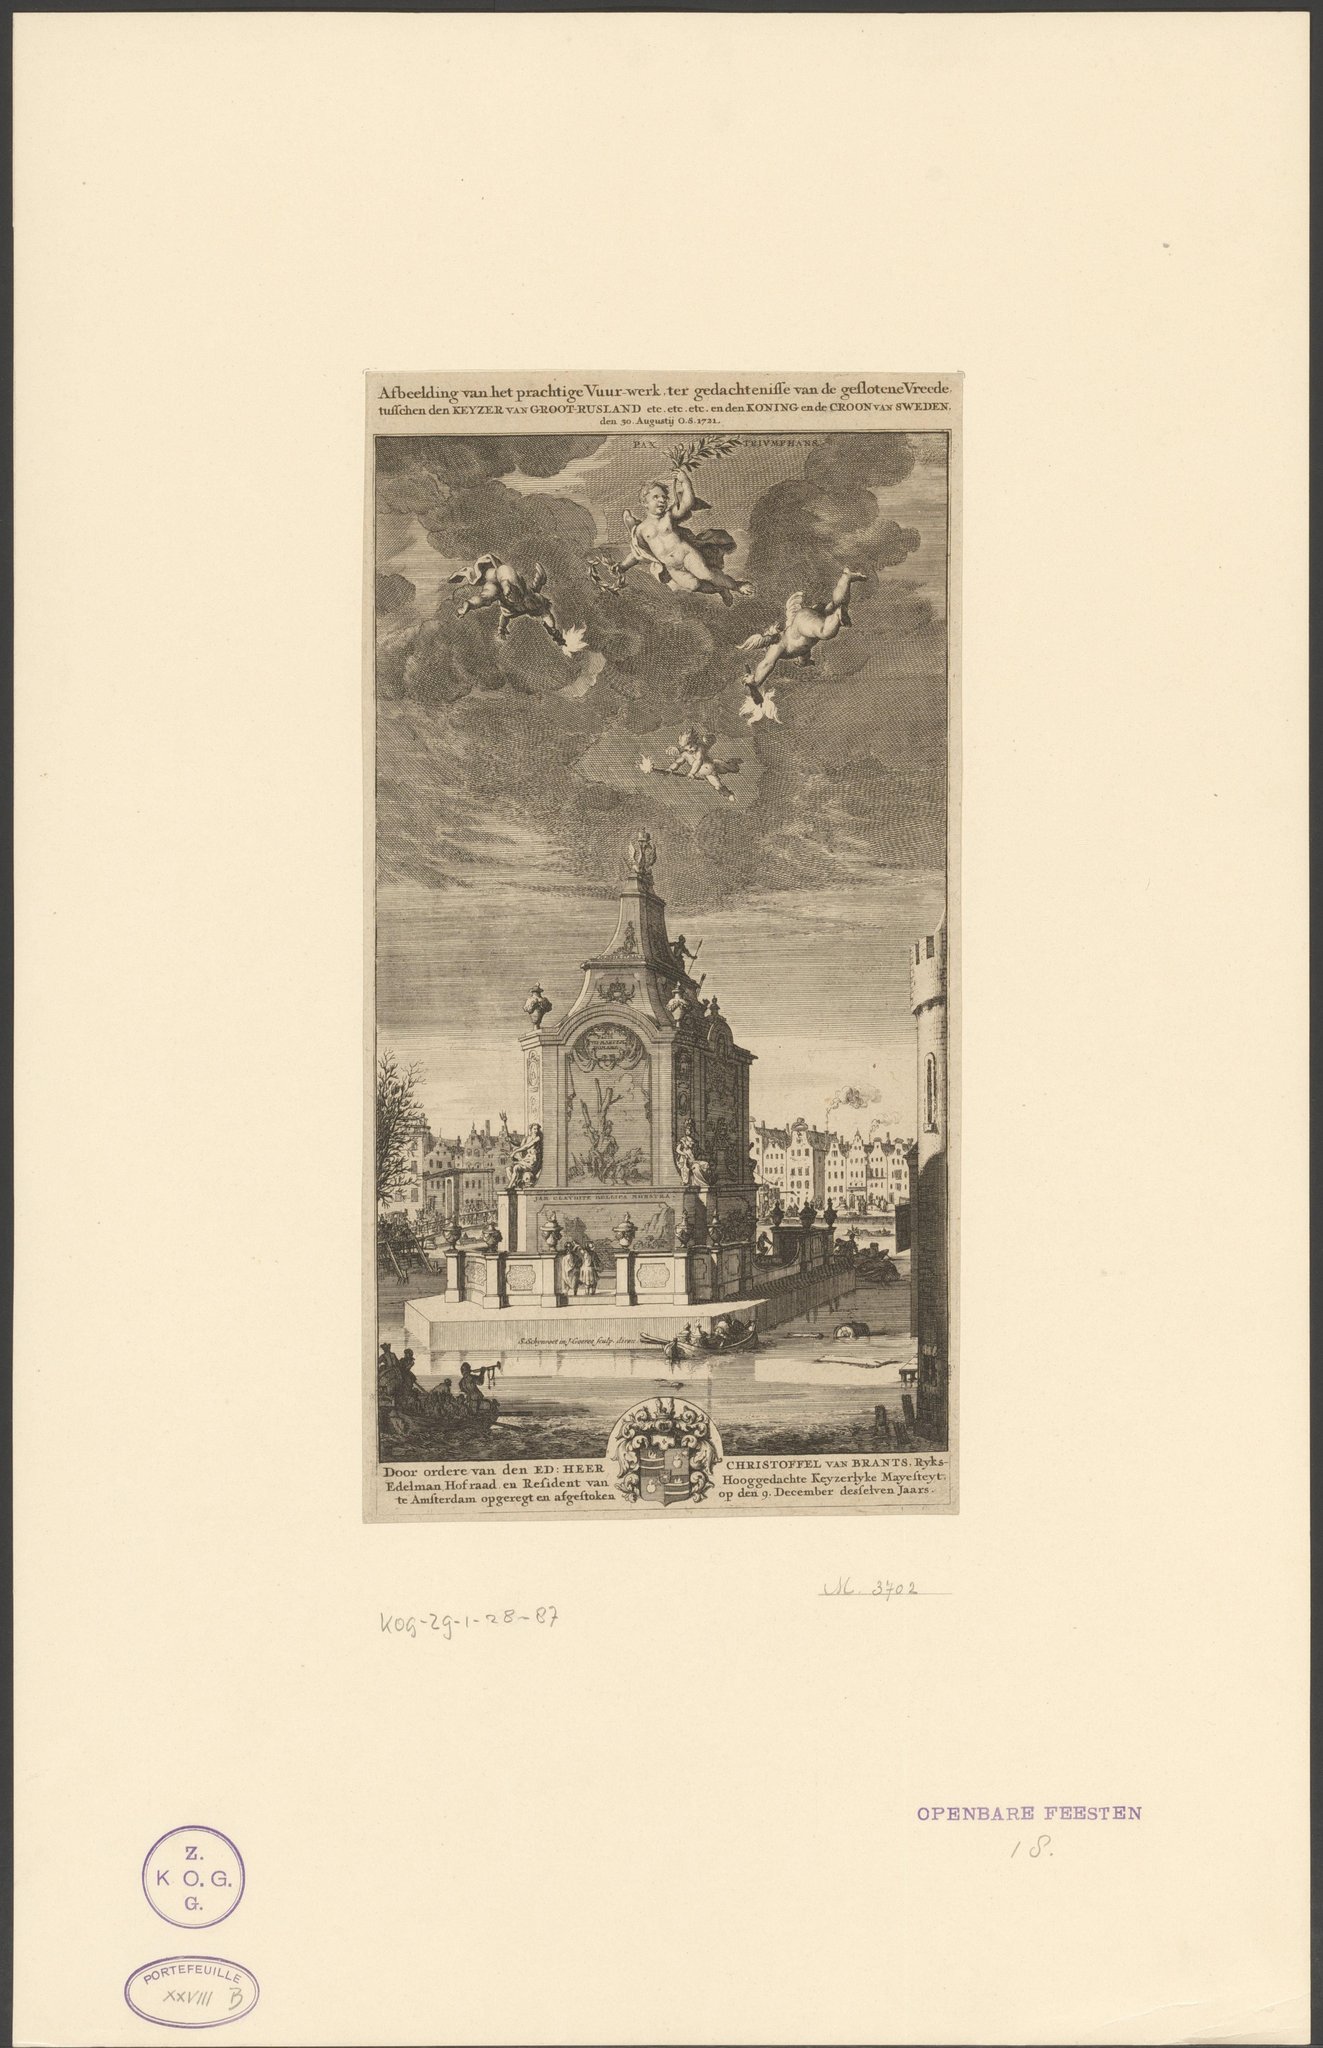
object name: print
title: Tempel der Vrede voor het vuurwerk van 30 augustus 1721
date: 1721-1723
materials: paper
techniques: engraving, etching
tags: amsterdam, christoffel van brants, bonfire, fire-works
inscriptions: stamp, collector's mark: Lugt 1641, stamp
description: Voorbereidingen rond de Tempel der Vrede, het middelpunt van het vuurwerk afgestoken op 9 december 1721 op de Binnen-Amstel bij de Kloveniersburgwal ter gedachtenis van de Vrede van Nystad gesloten tussen Rusland en Zweden op 10 september 1721. In de lucht vier engeltjes, rechts een stuk van de toren Swygh Utrecht. Het vuurwerk geleverd in opdracht van Christoffel van Brants, vertegenwoordiger van de Russische kroon te Amsterdam. Onderwerpsrubrieken binnen de Atlas Zeden en Gewoonten: Zeden en Gewoonten in Engeren Zin. Volksleven. Openbare feesten. Vorstelijke intochten, (Illuminaties, vuurwerken en dergelijke, openbare feesten).